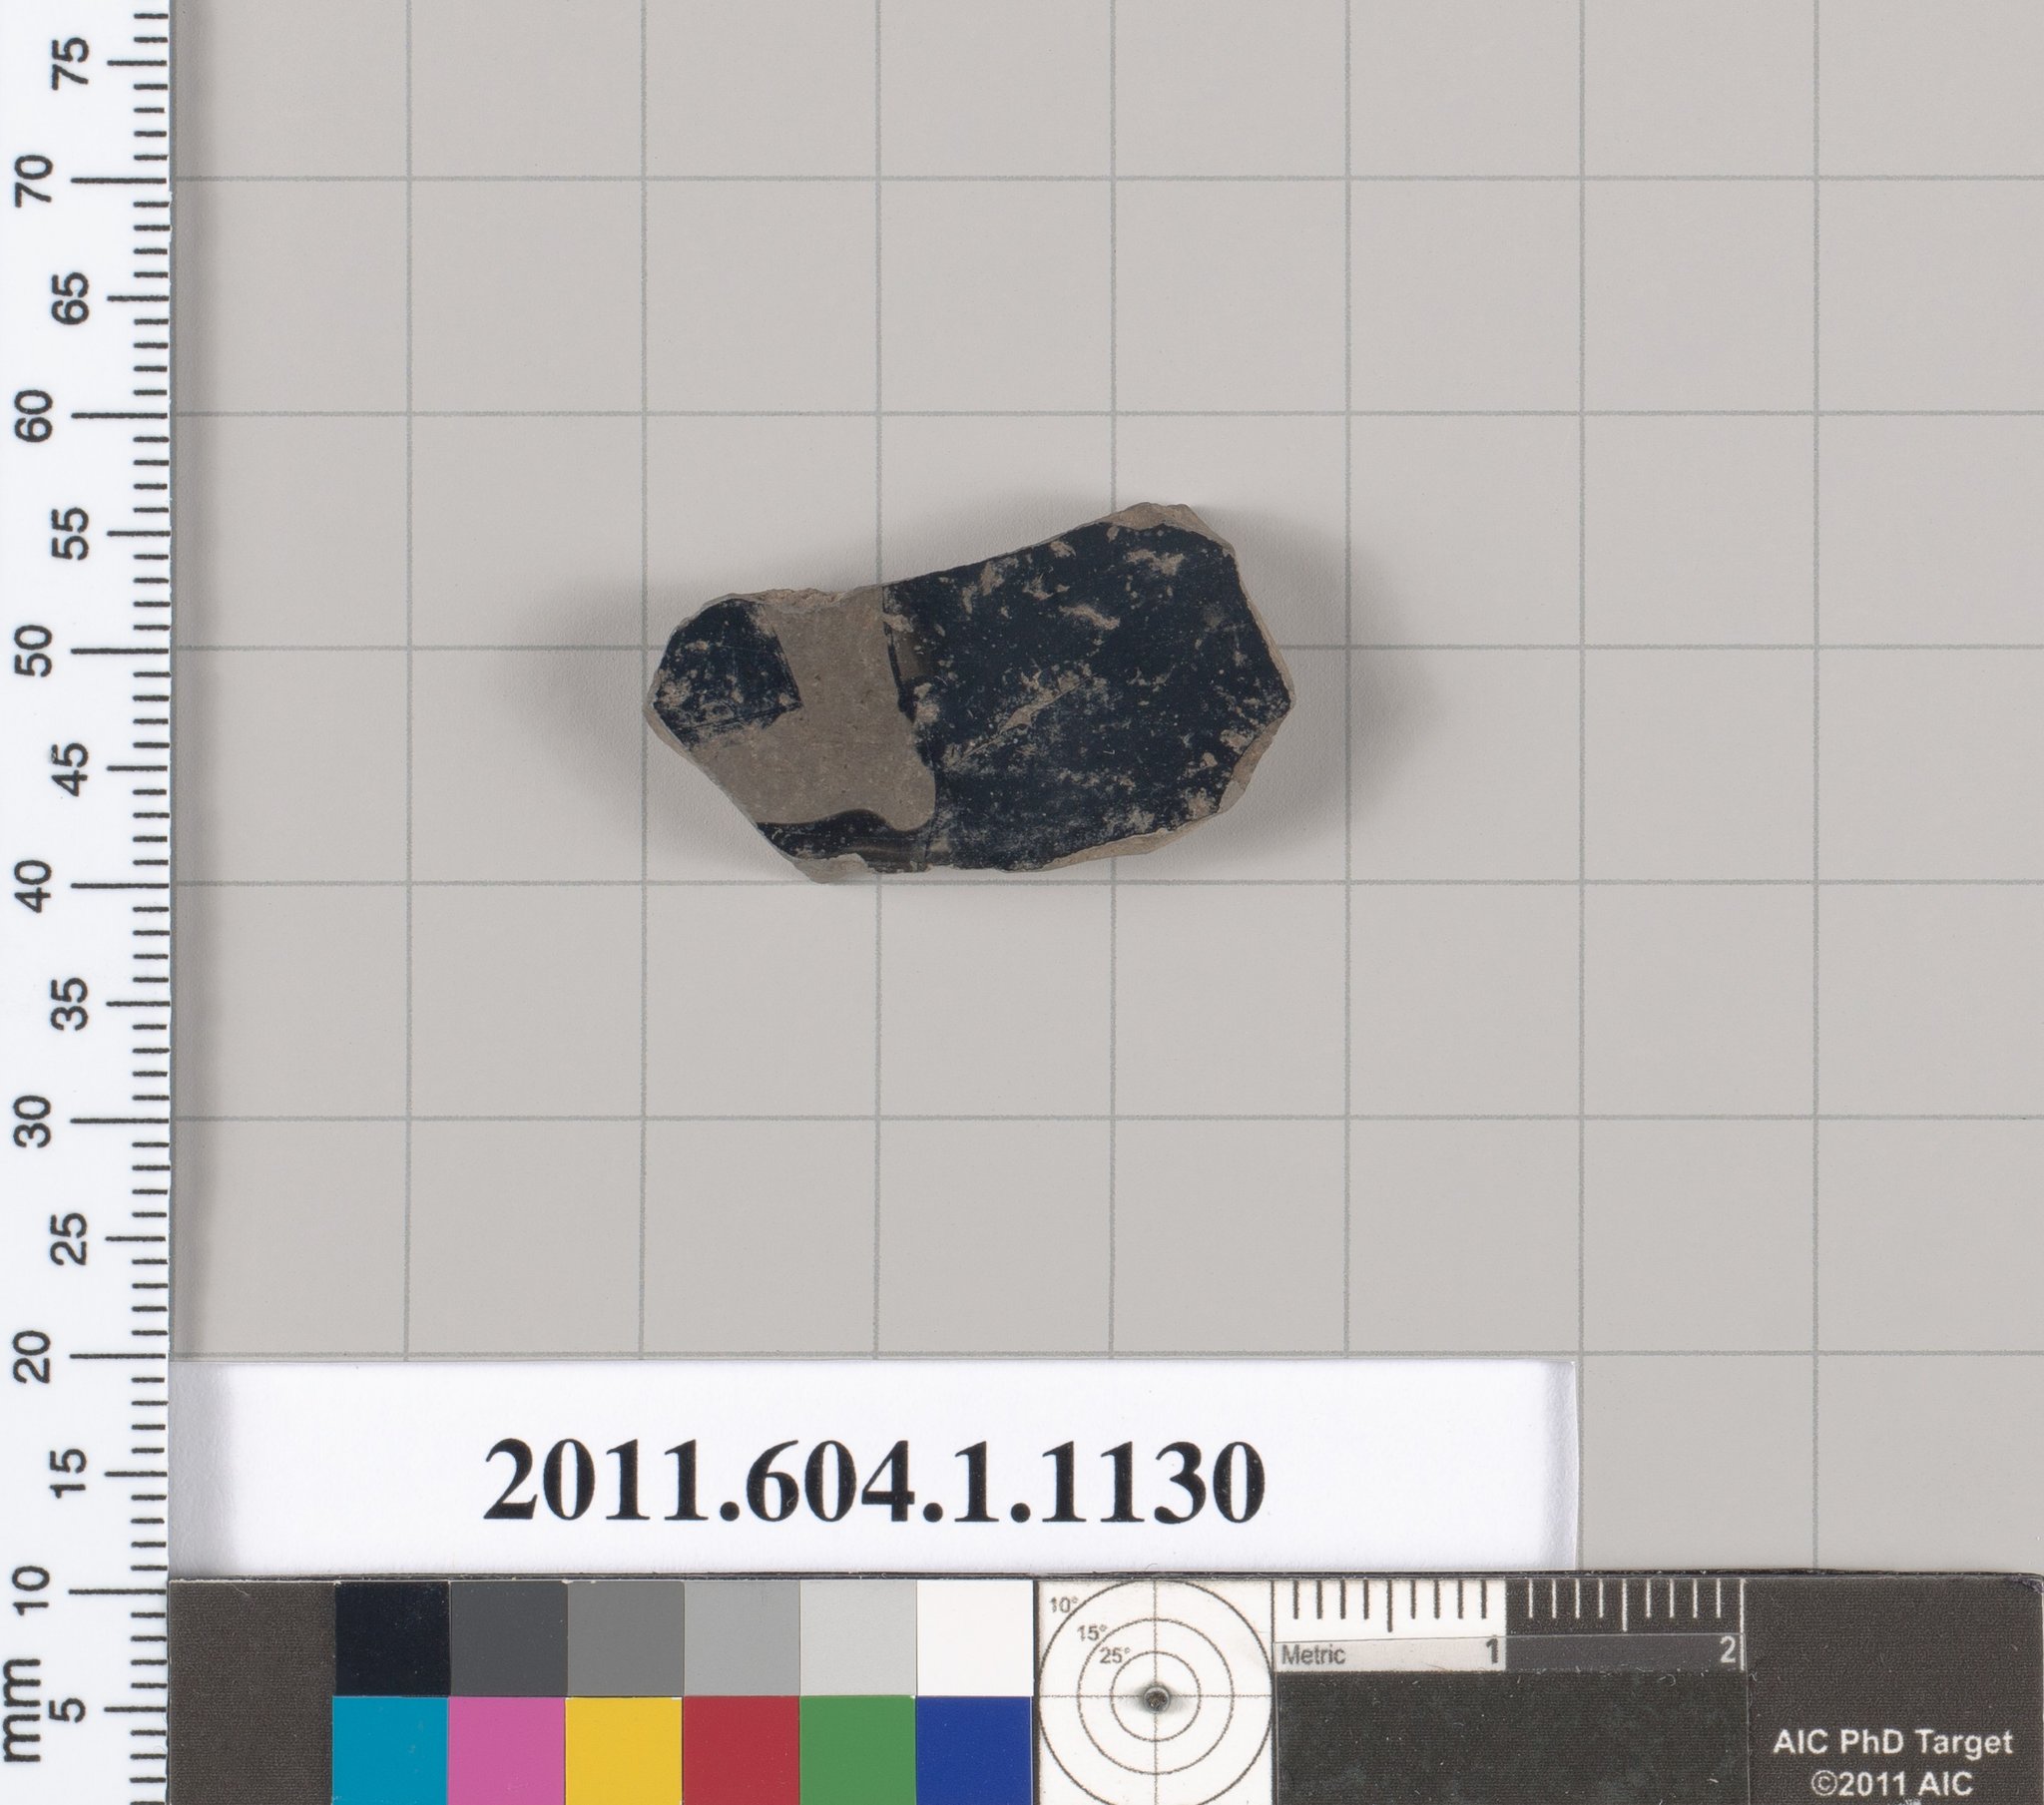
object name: kylix fragment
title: Terracotta fragment of a kylix (drinking cup)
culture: greek, attic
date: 475-451 BCE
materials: terracotta